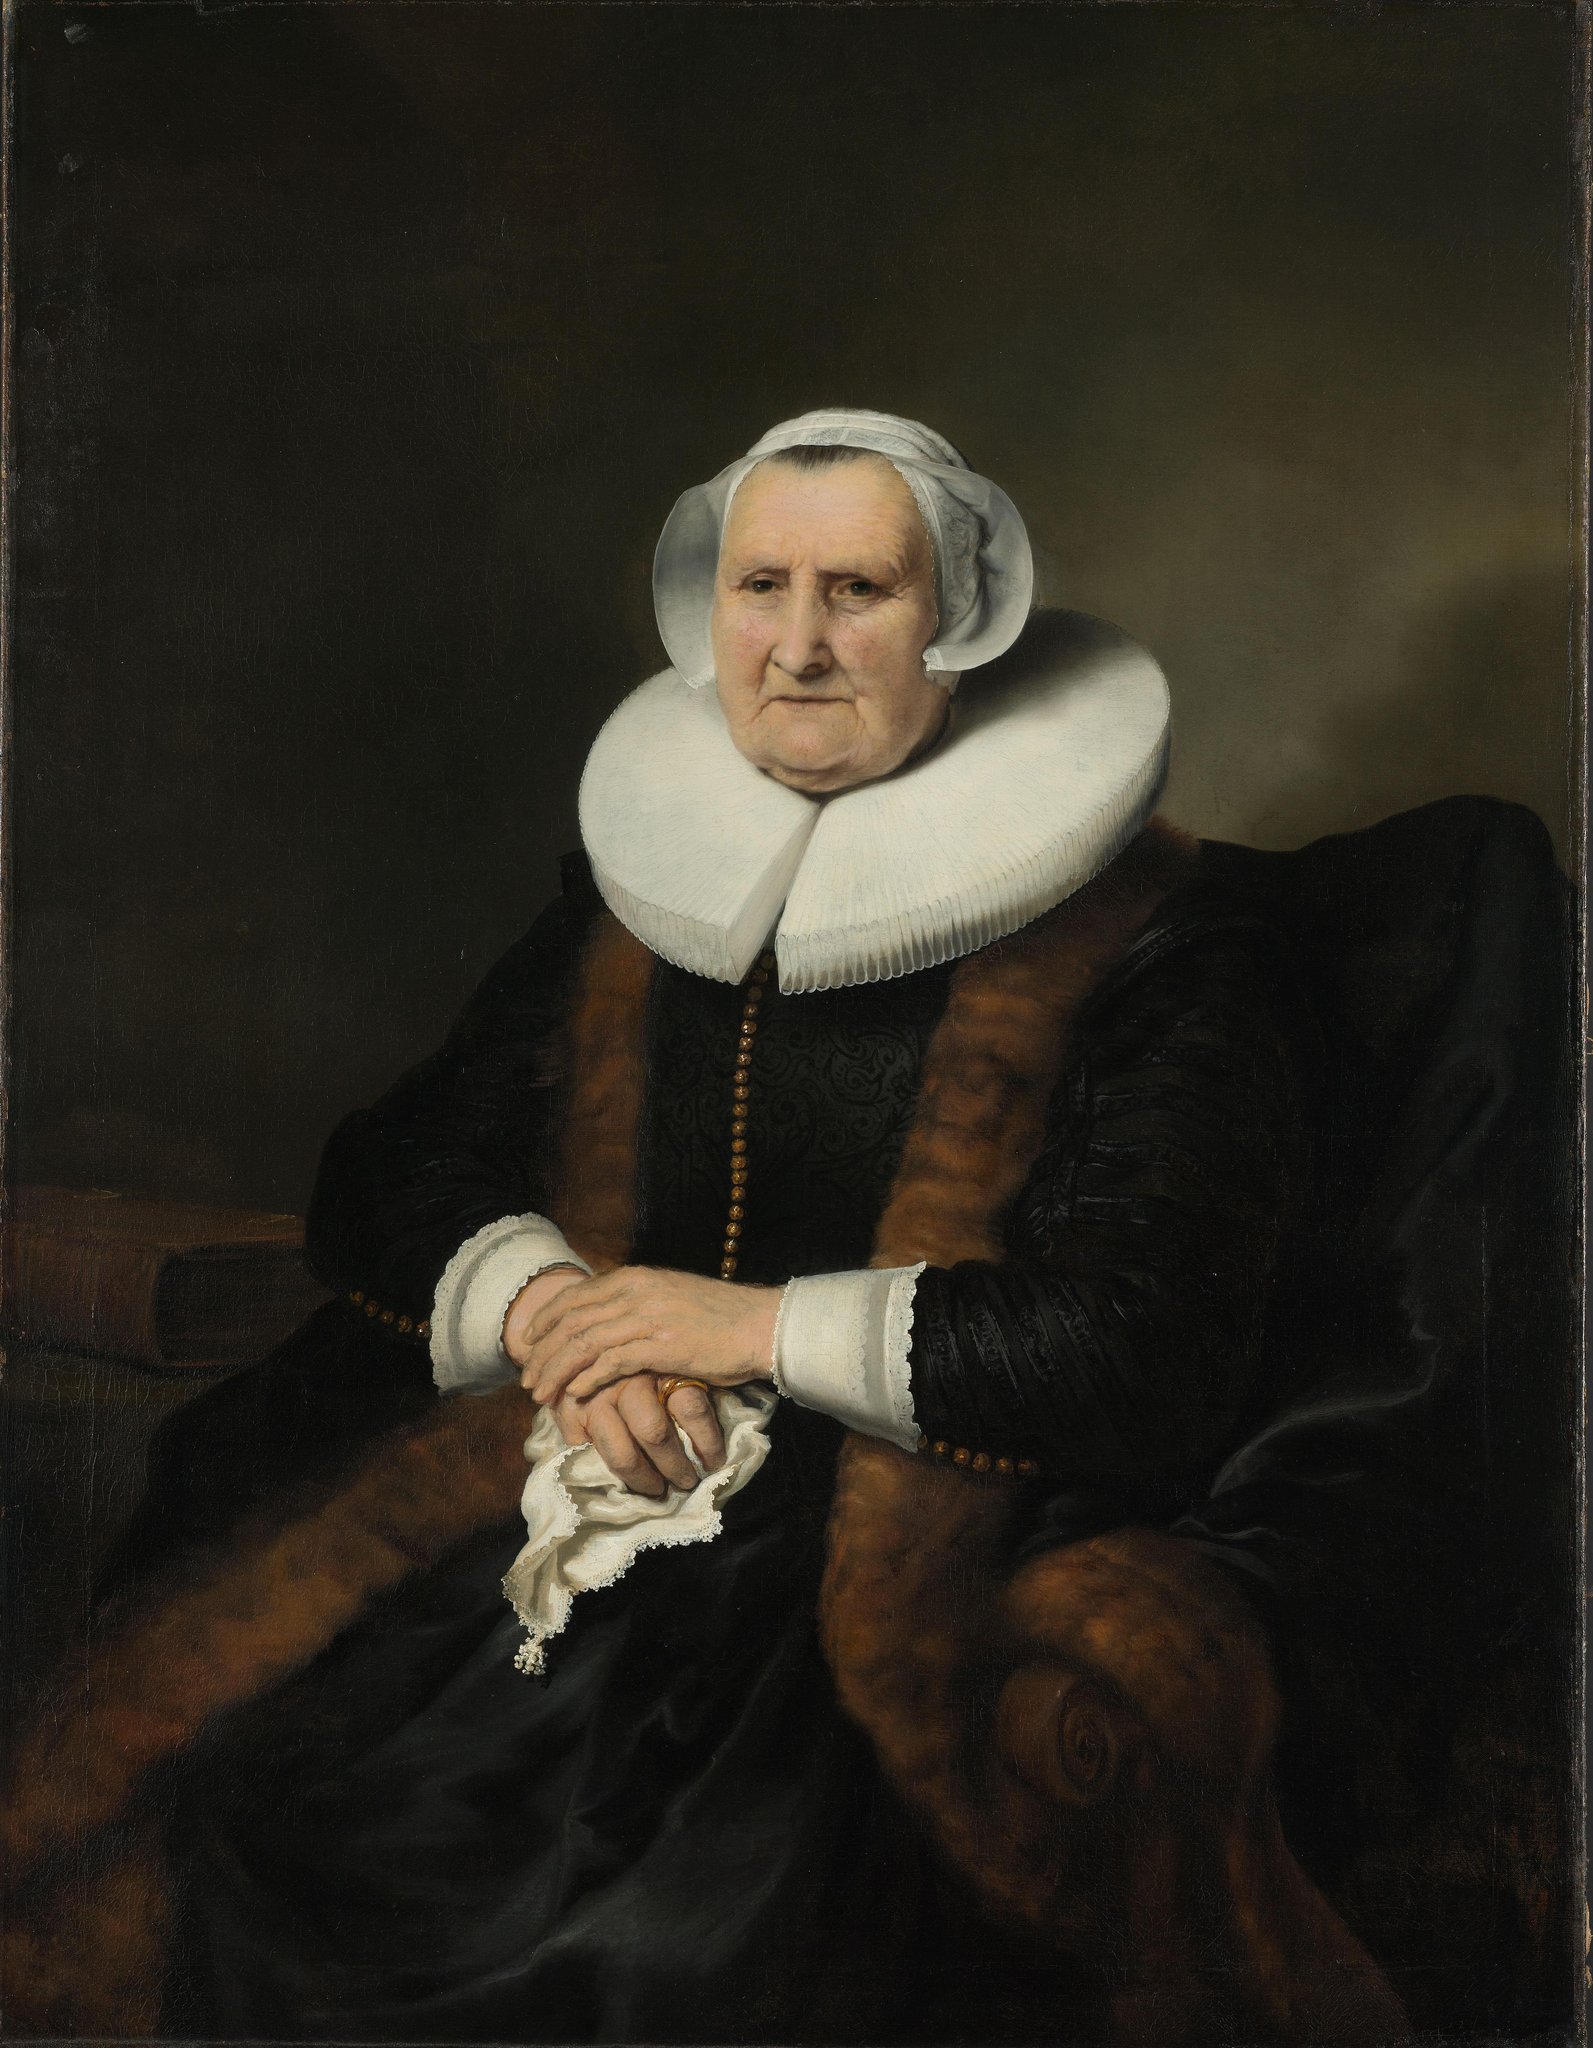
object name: painting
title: Elisabeth Jacobsdr Bas (1571-1649), Widow of Jochem Hendricksz Swartenhont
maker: ferdinand bol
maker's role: draughtsman, painter, print maker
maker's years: 1616-1680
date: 1640-1645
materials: canvas, oil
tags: amsterdam, historical persons - bb - woman (+ half-length portrait)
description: This portrait may depict Elisabeth Bas. Like many seafarers’ wives, Bas managed the provisioning of the fleet of her husband, Admiral Jochem Swartenhondt. Together with him, she also ran a distinguished inn, which she continued on her own after his demise. This painting was long attributed to Rembrandt, but it was painted in his style by one of his pupils, Ferdinand Bol.